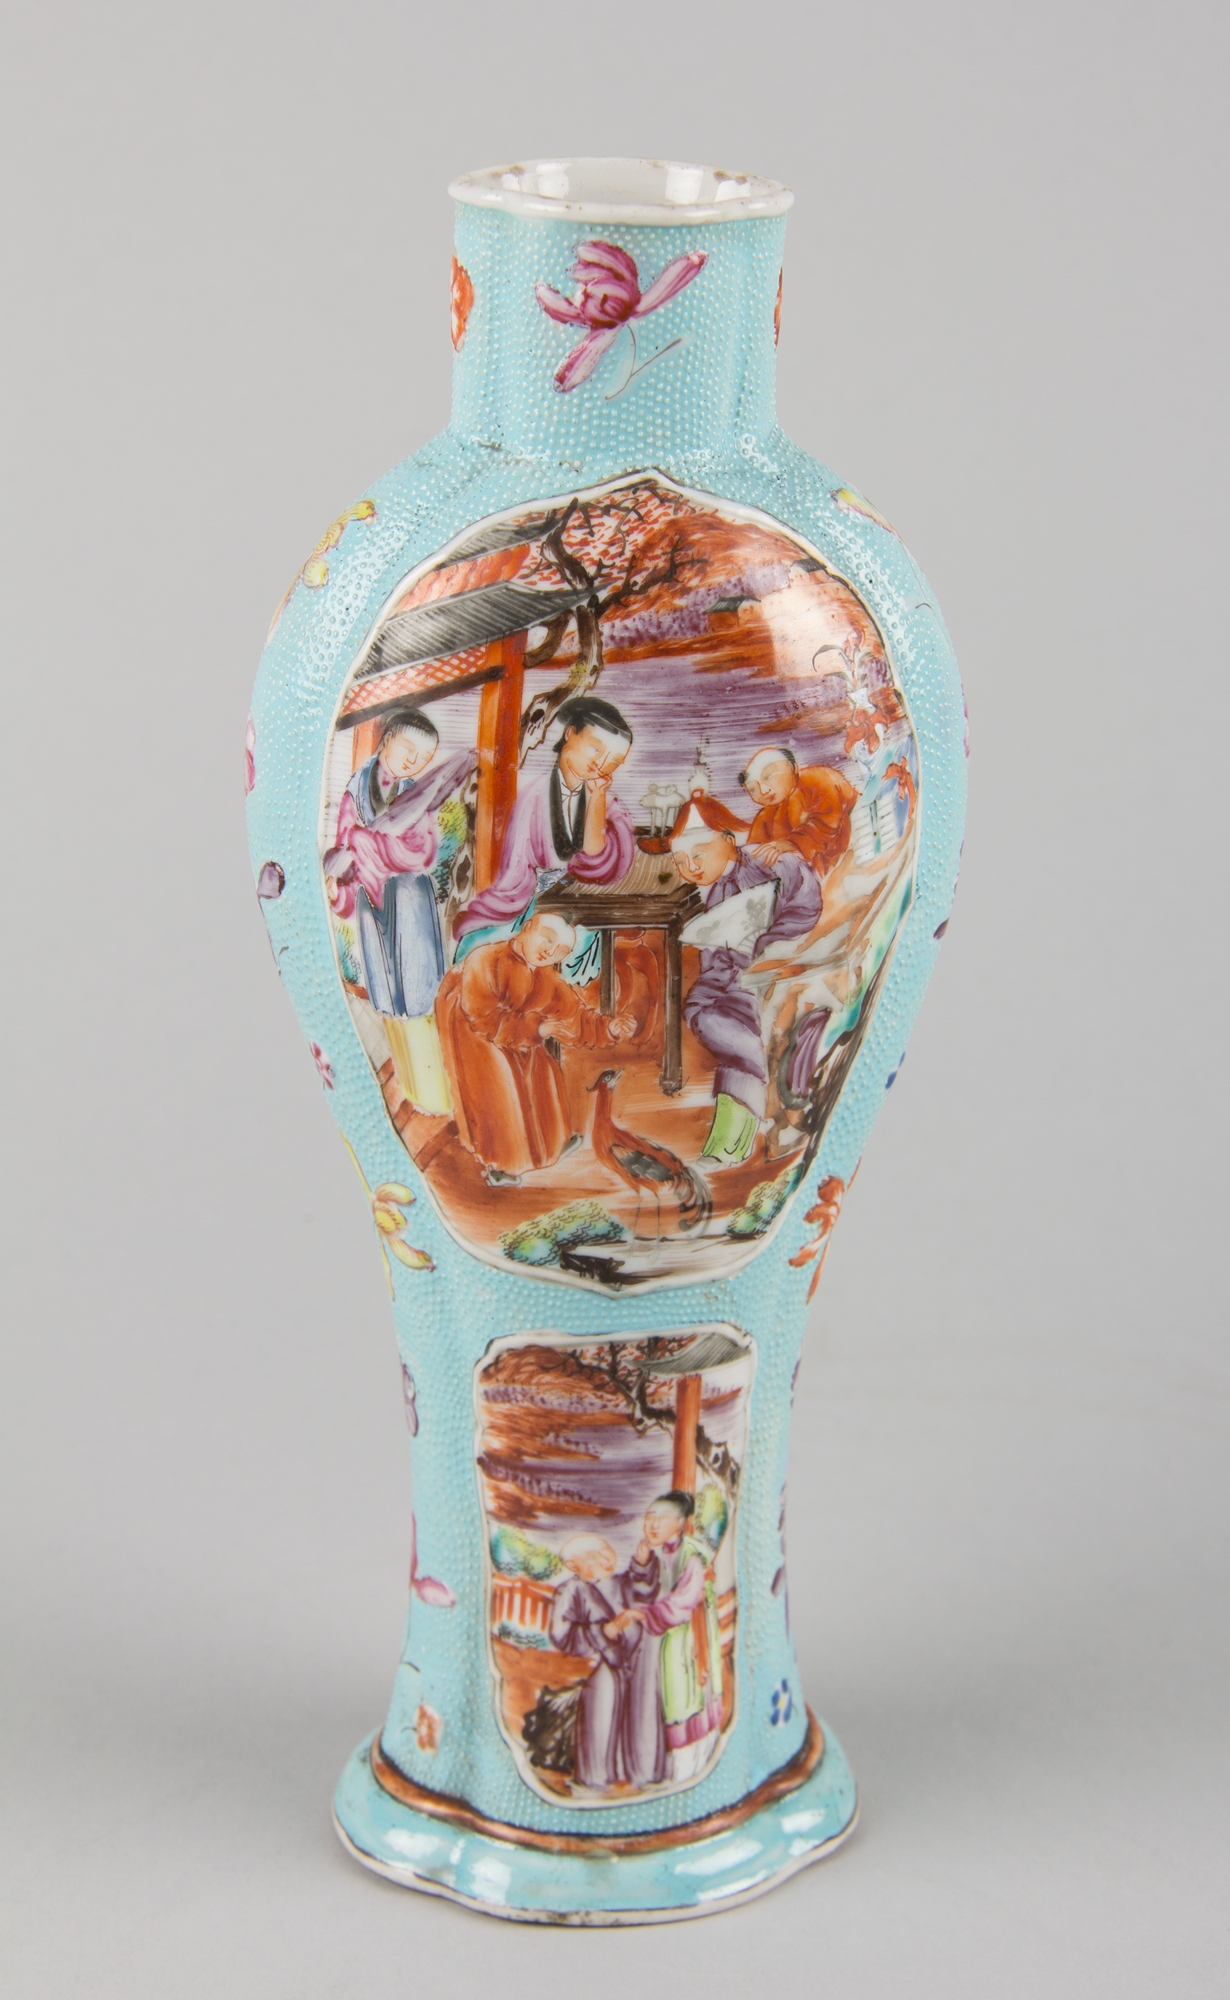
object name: vase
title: Vase with ladies and boys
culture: chinese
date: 1767-1900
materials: enamel, porcelain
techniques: overglaze, painting, polychrome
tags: birds,boys,women